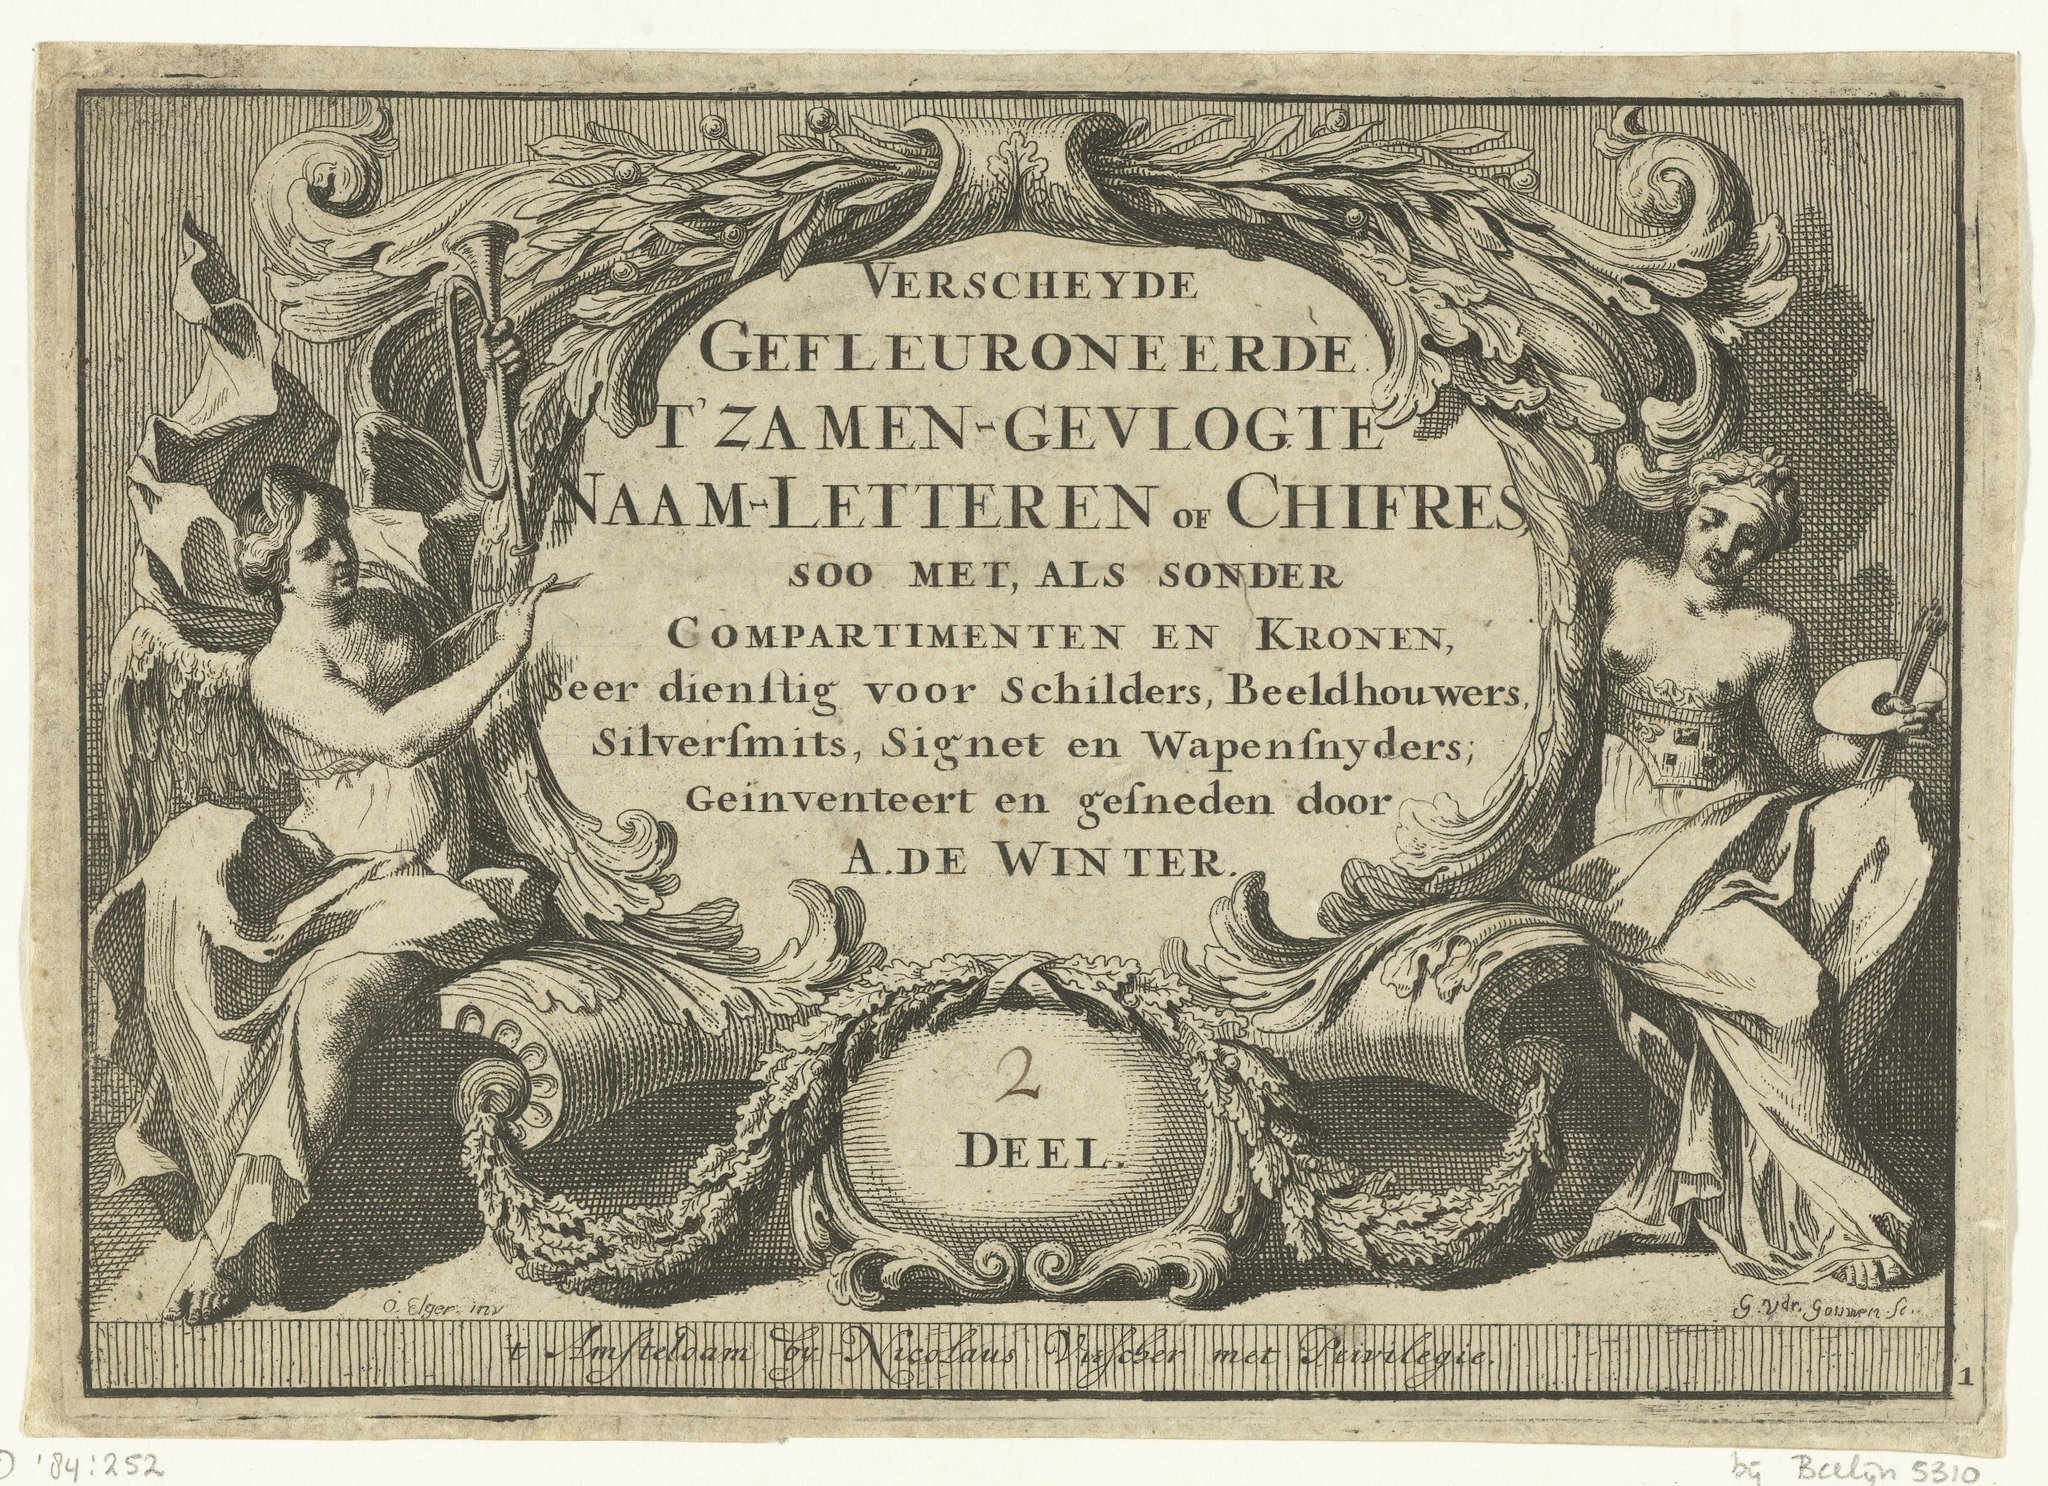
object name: titelprent, frontispice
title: Titelblad: Verscheyde Gefleuroneerde T'Zamen-Gevlogte Naam-Letteren of Chifres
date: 1690-1702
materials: paper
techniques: engraving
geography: amsterdam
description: Titel in cartouche, geflankeerd door twee halfnaakte vrouwen: een allegorie van Muziek en de Schilderkunst.